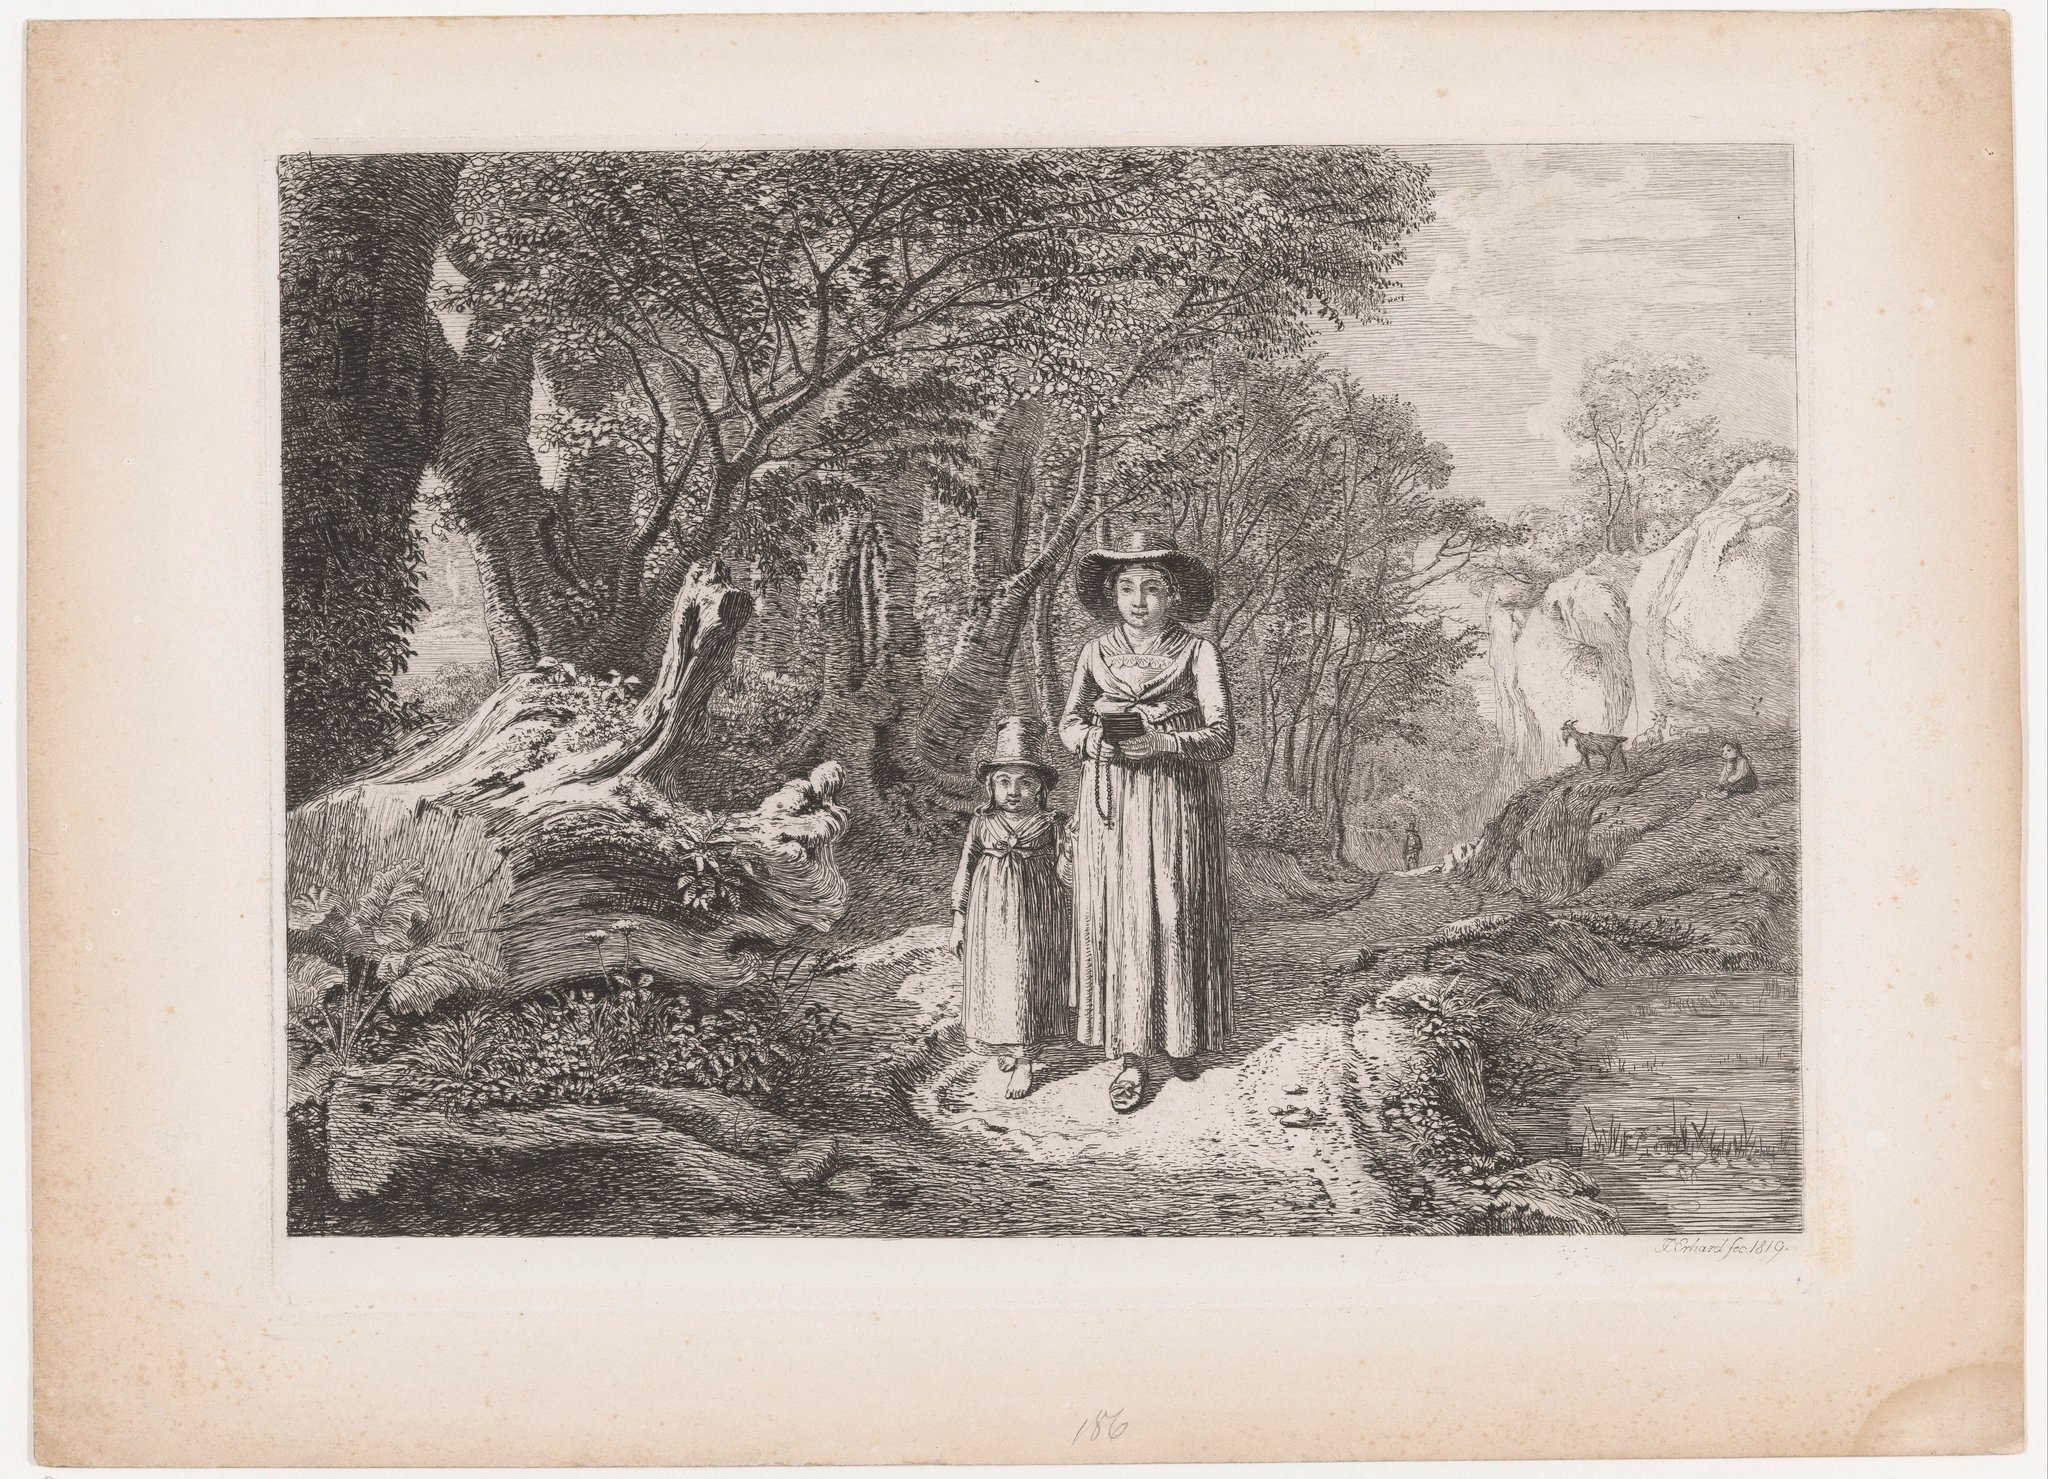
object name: print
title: Salzburgse landschappen met figuren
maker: johann christoph erhard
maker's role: print maker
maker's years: 1795-1882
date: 1819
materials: paper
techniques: etching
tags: going to church, forest, wood, mother and daughter(s) (family group)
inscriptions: collector's mark: Lugt 2228, collector's mark: Lugt 2760